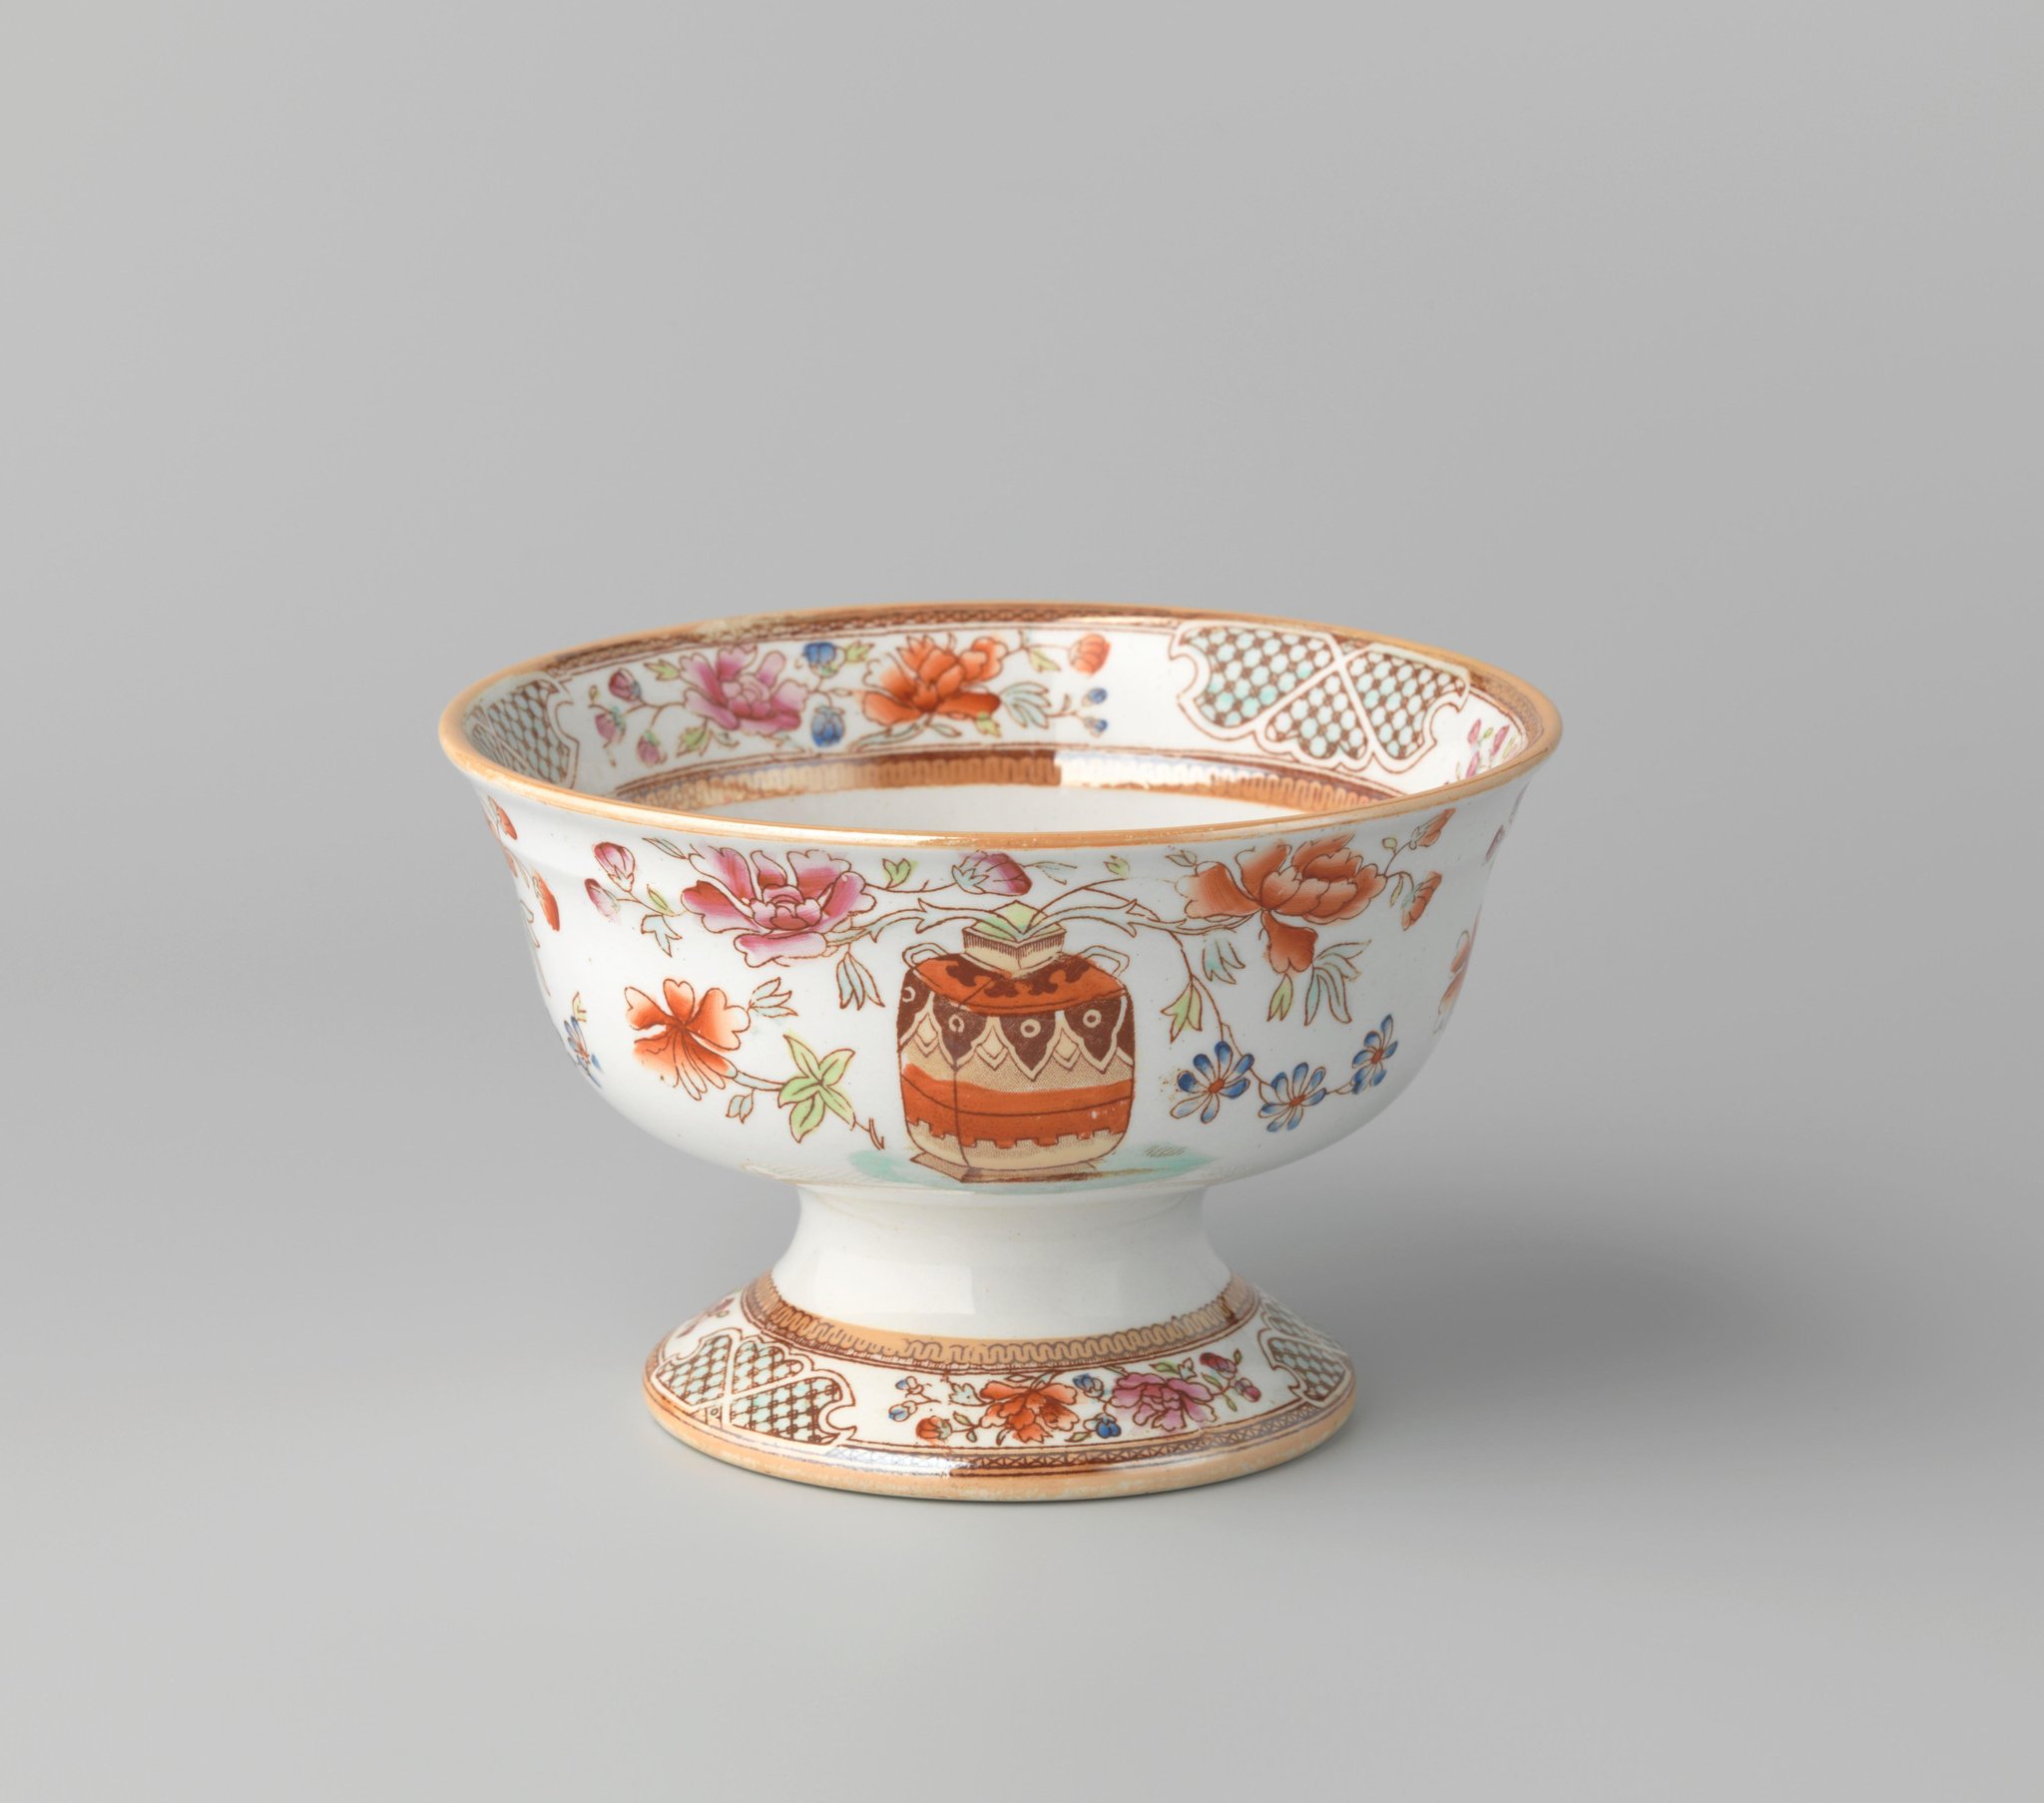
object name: bowl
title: Kastkom op voet, met veelkleurige voorstelling van potten met bloeiende takken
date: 1895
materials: earthenware, glaze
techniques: vitrification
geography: maastricht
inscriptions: mark: ‘sfinx // PETRUS REGOUT & Co. // MAASTRICHT // FLORA // MADE IN HOLLAND’, check stamp: ‘E 2’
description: Kastkom op voet van aardewerk met bruine transferdruk, beschilderd met moffelkleuren en okerluster. De wanden gedecoreerd met veelkleurige voorstellingen van potten met bloeiende takken. De voetrand en de binnenzijde van de wand gedecoreerd met een veelkleurige band met bloemen en abstracte ornamenten, afgezet met een bies in okerluster.